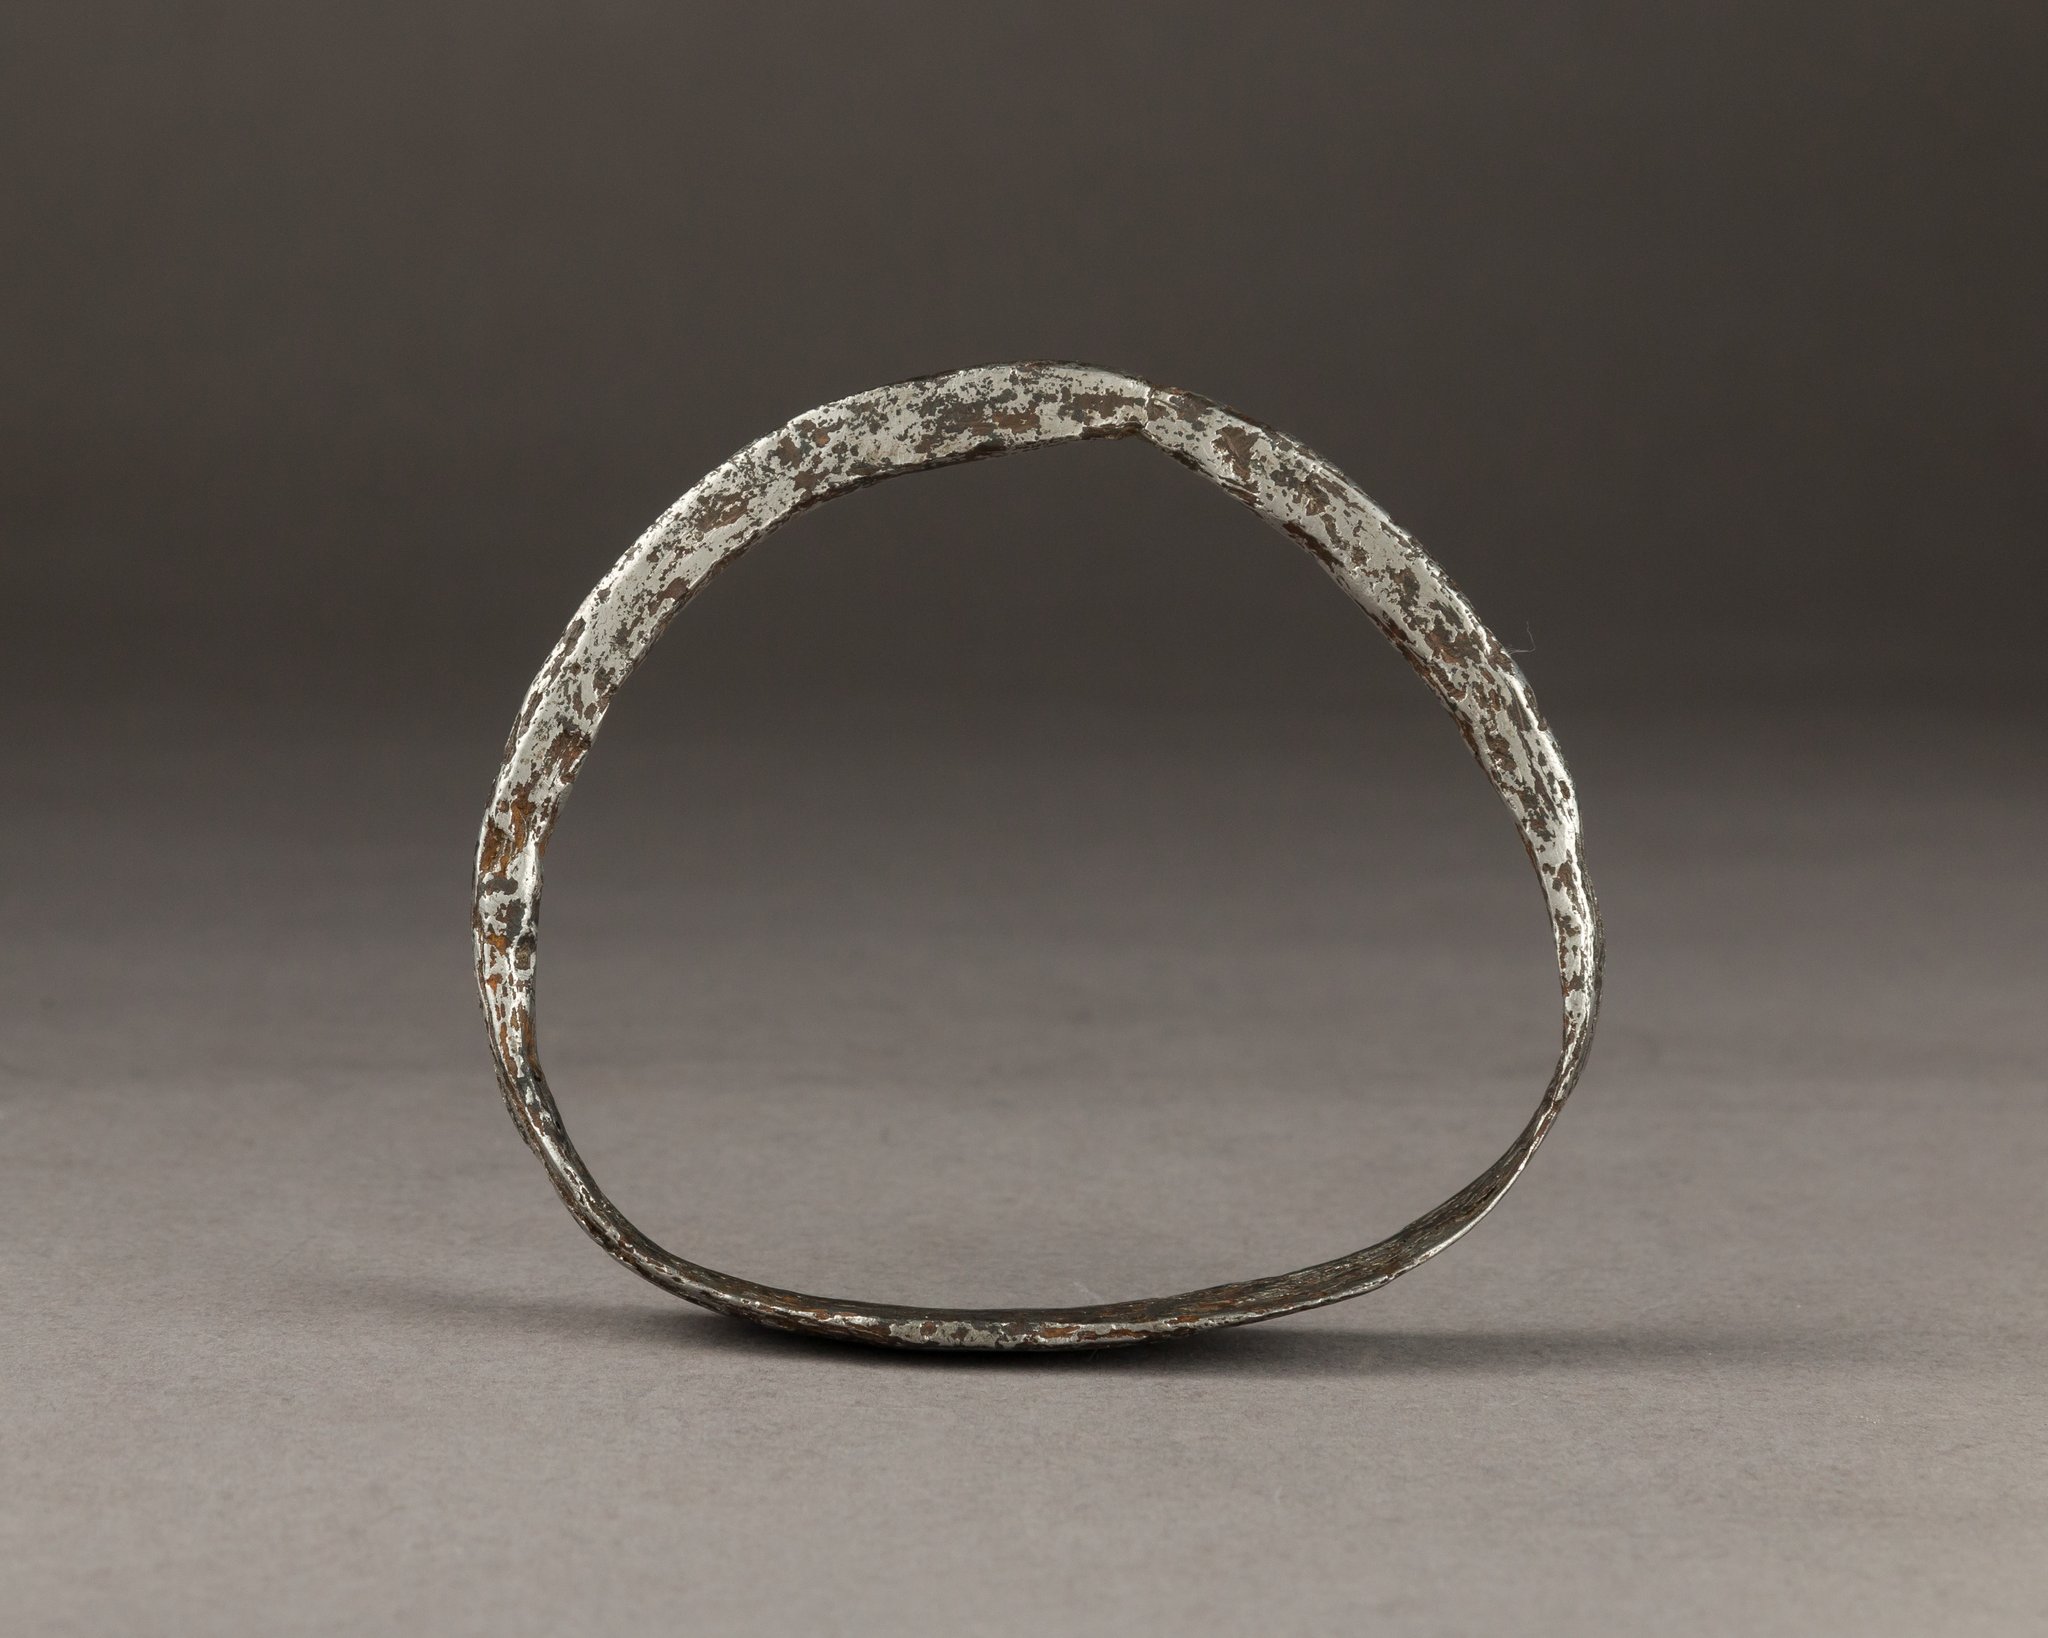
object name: stirrup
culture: west slavic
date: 901-1100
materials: iron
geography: poland